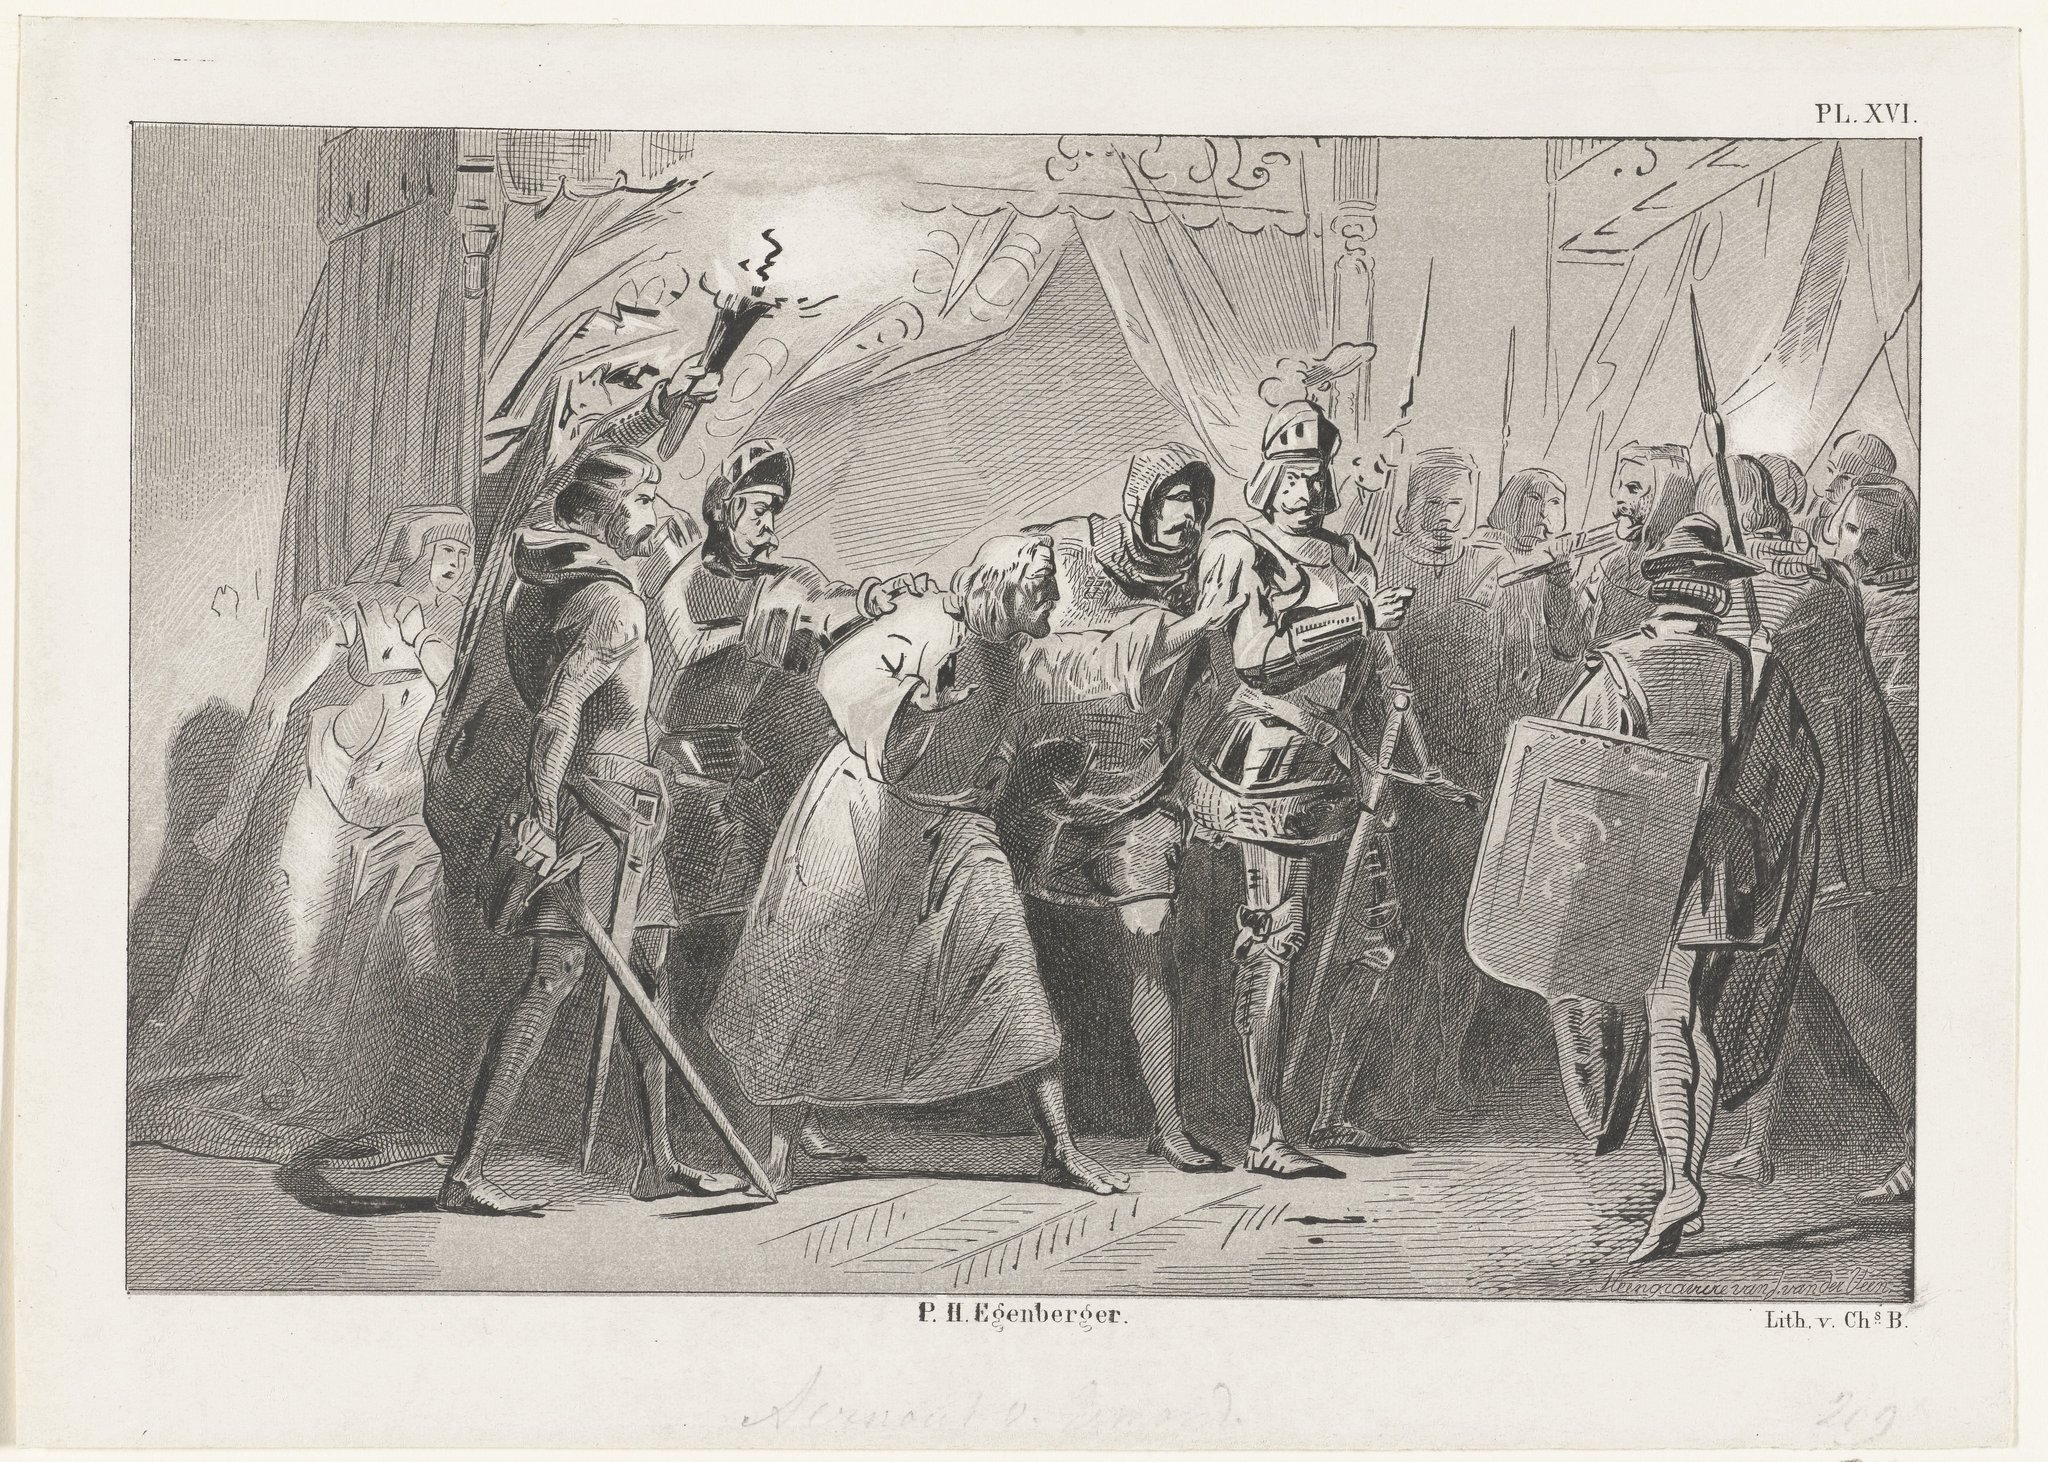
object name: print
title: Hertog Arnold van Gelre gedwongen afstand te doen van zijn rechten, 1465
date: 1853-1861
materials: paper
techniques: lithograph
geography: netherlands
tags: grave, burgundian netherlands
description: Arnold van Egmond, hertog van Gelre wordt op het kasteel te Grave van zijn bed gelicht door soldaten van zijn zoon Adolf en gedwongen afstand te doen van zijn rechten, 1465.